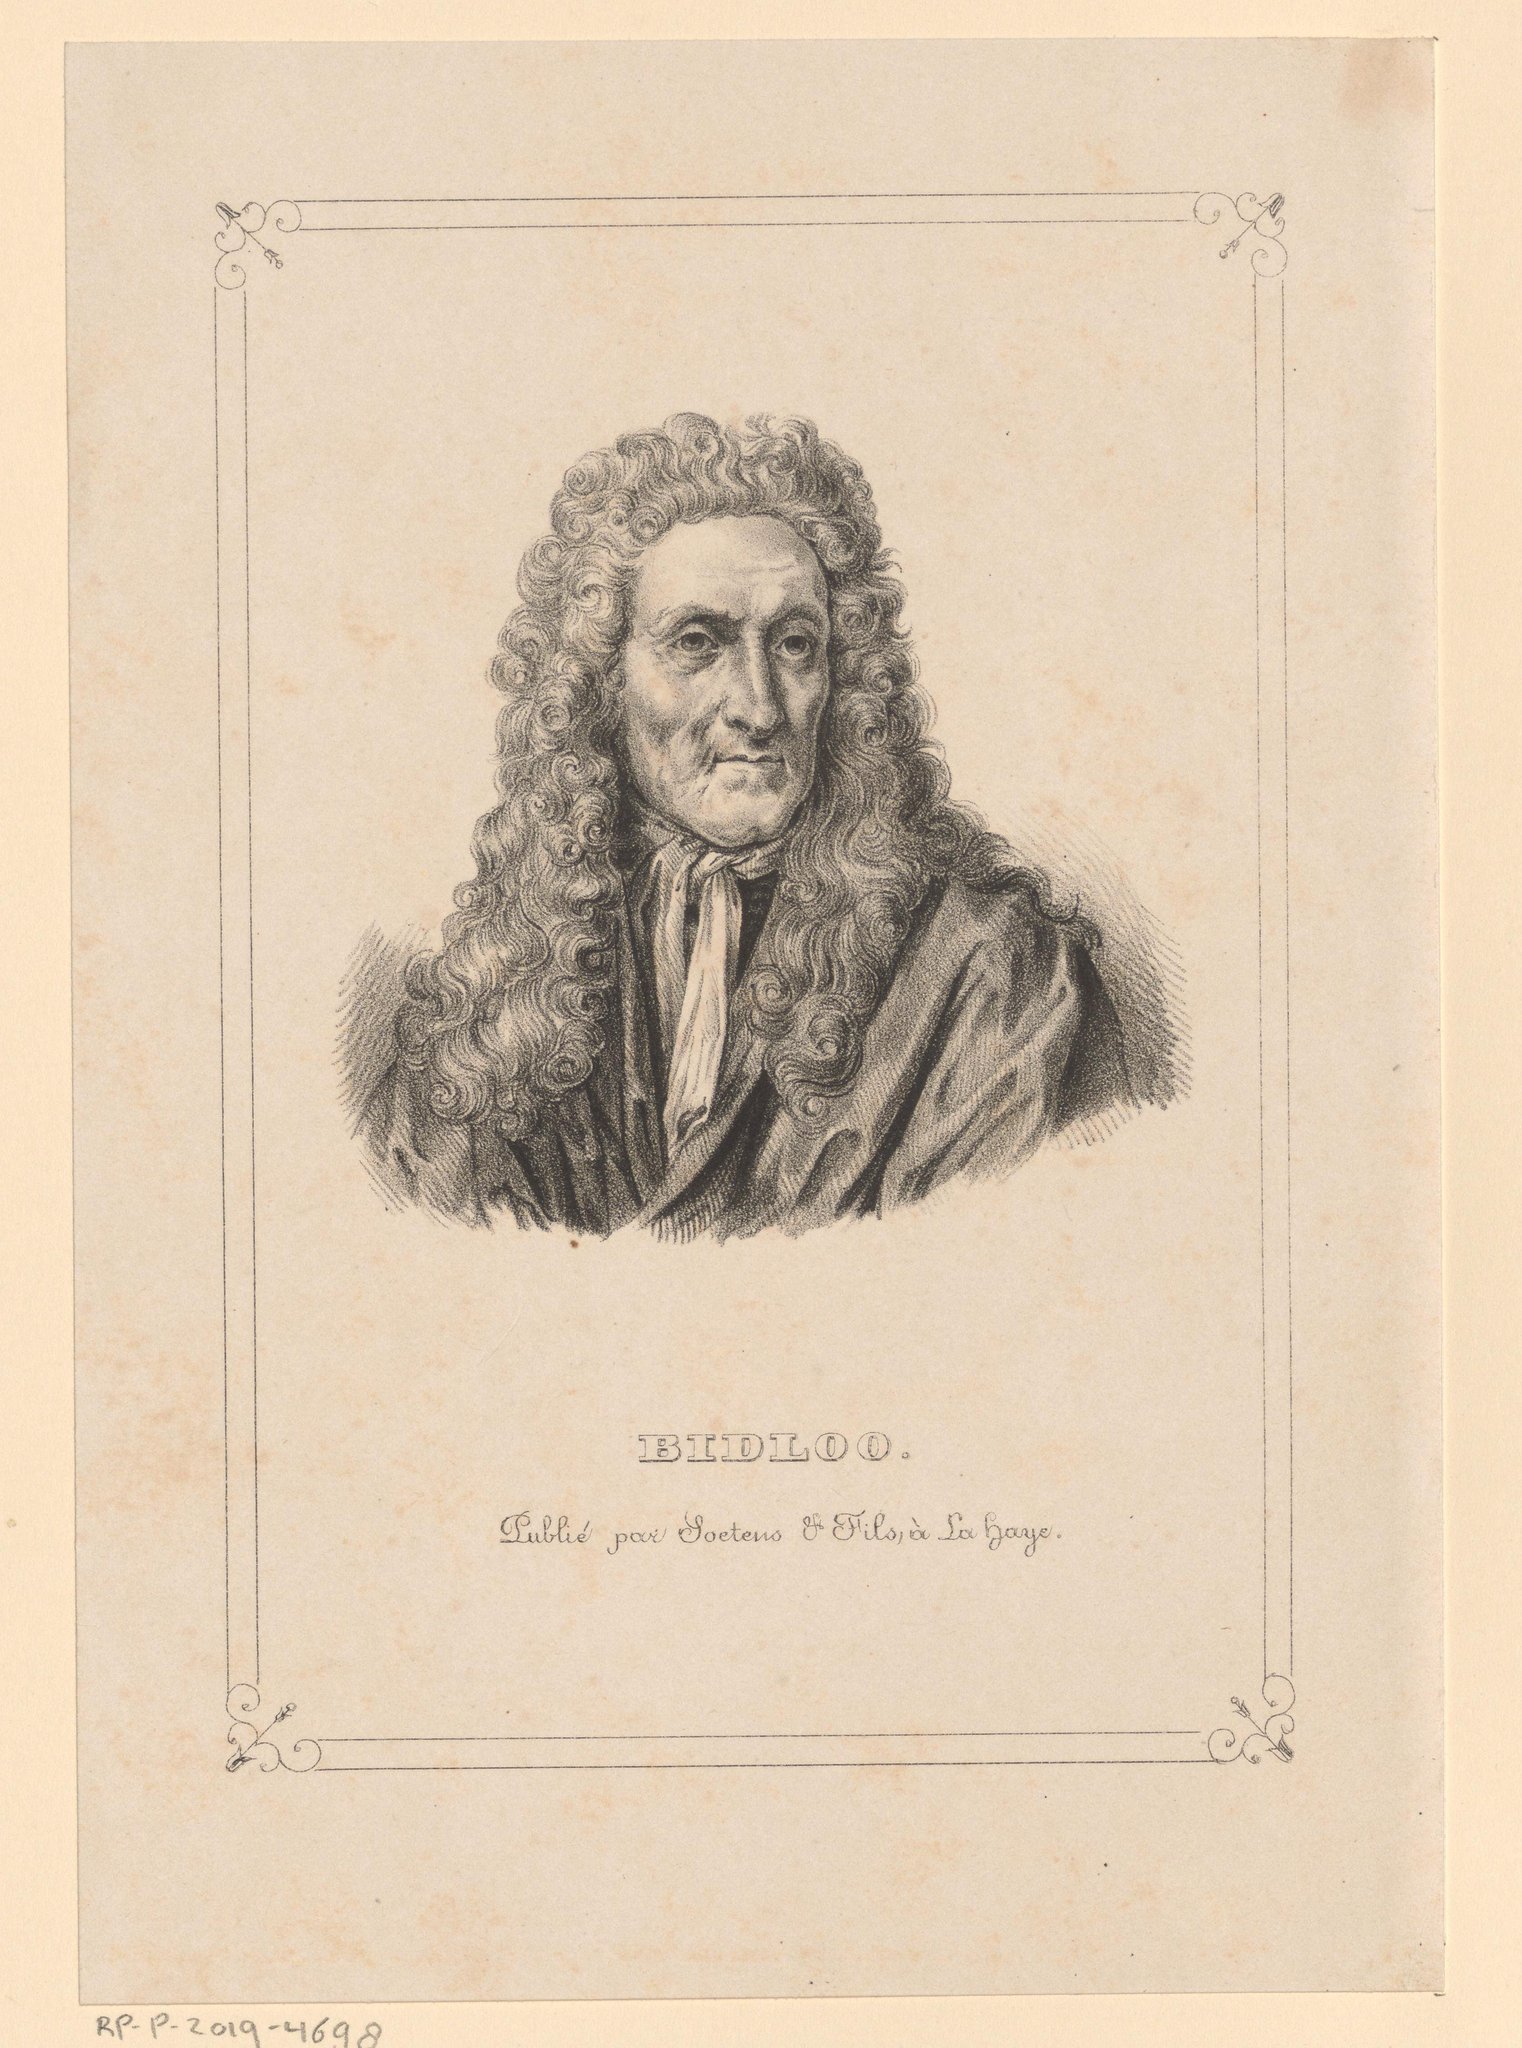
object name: print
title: Portret van Lambert Bidloo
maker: Anonymous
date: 1837-1840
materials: paper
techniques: lithograph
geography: the hague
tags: lambert bidloo, pharmacist, druggist, apothecary; pharmacy, drugstore, dispensing chemist, historical persons, writer, poet, author